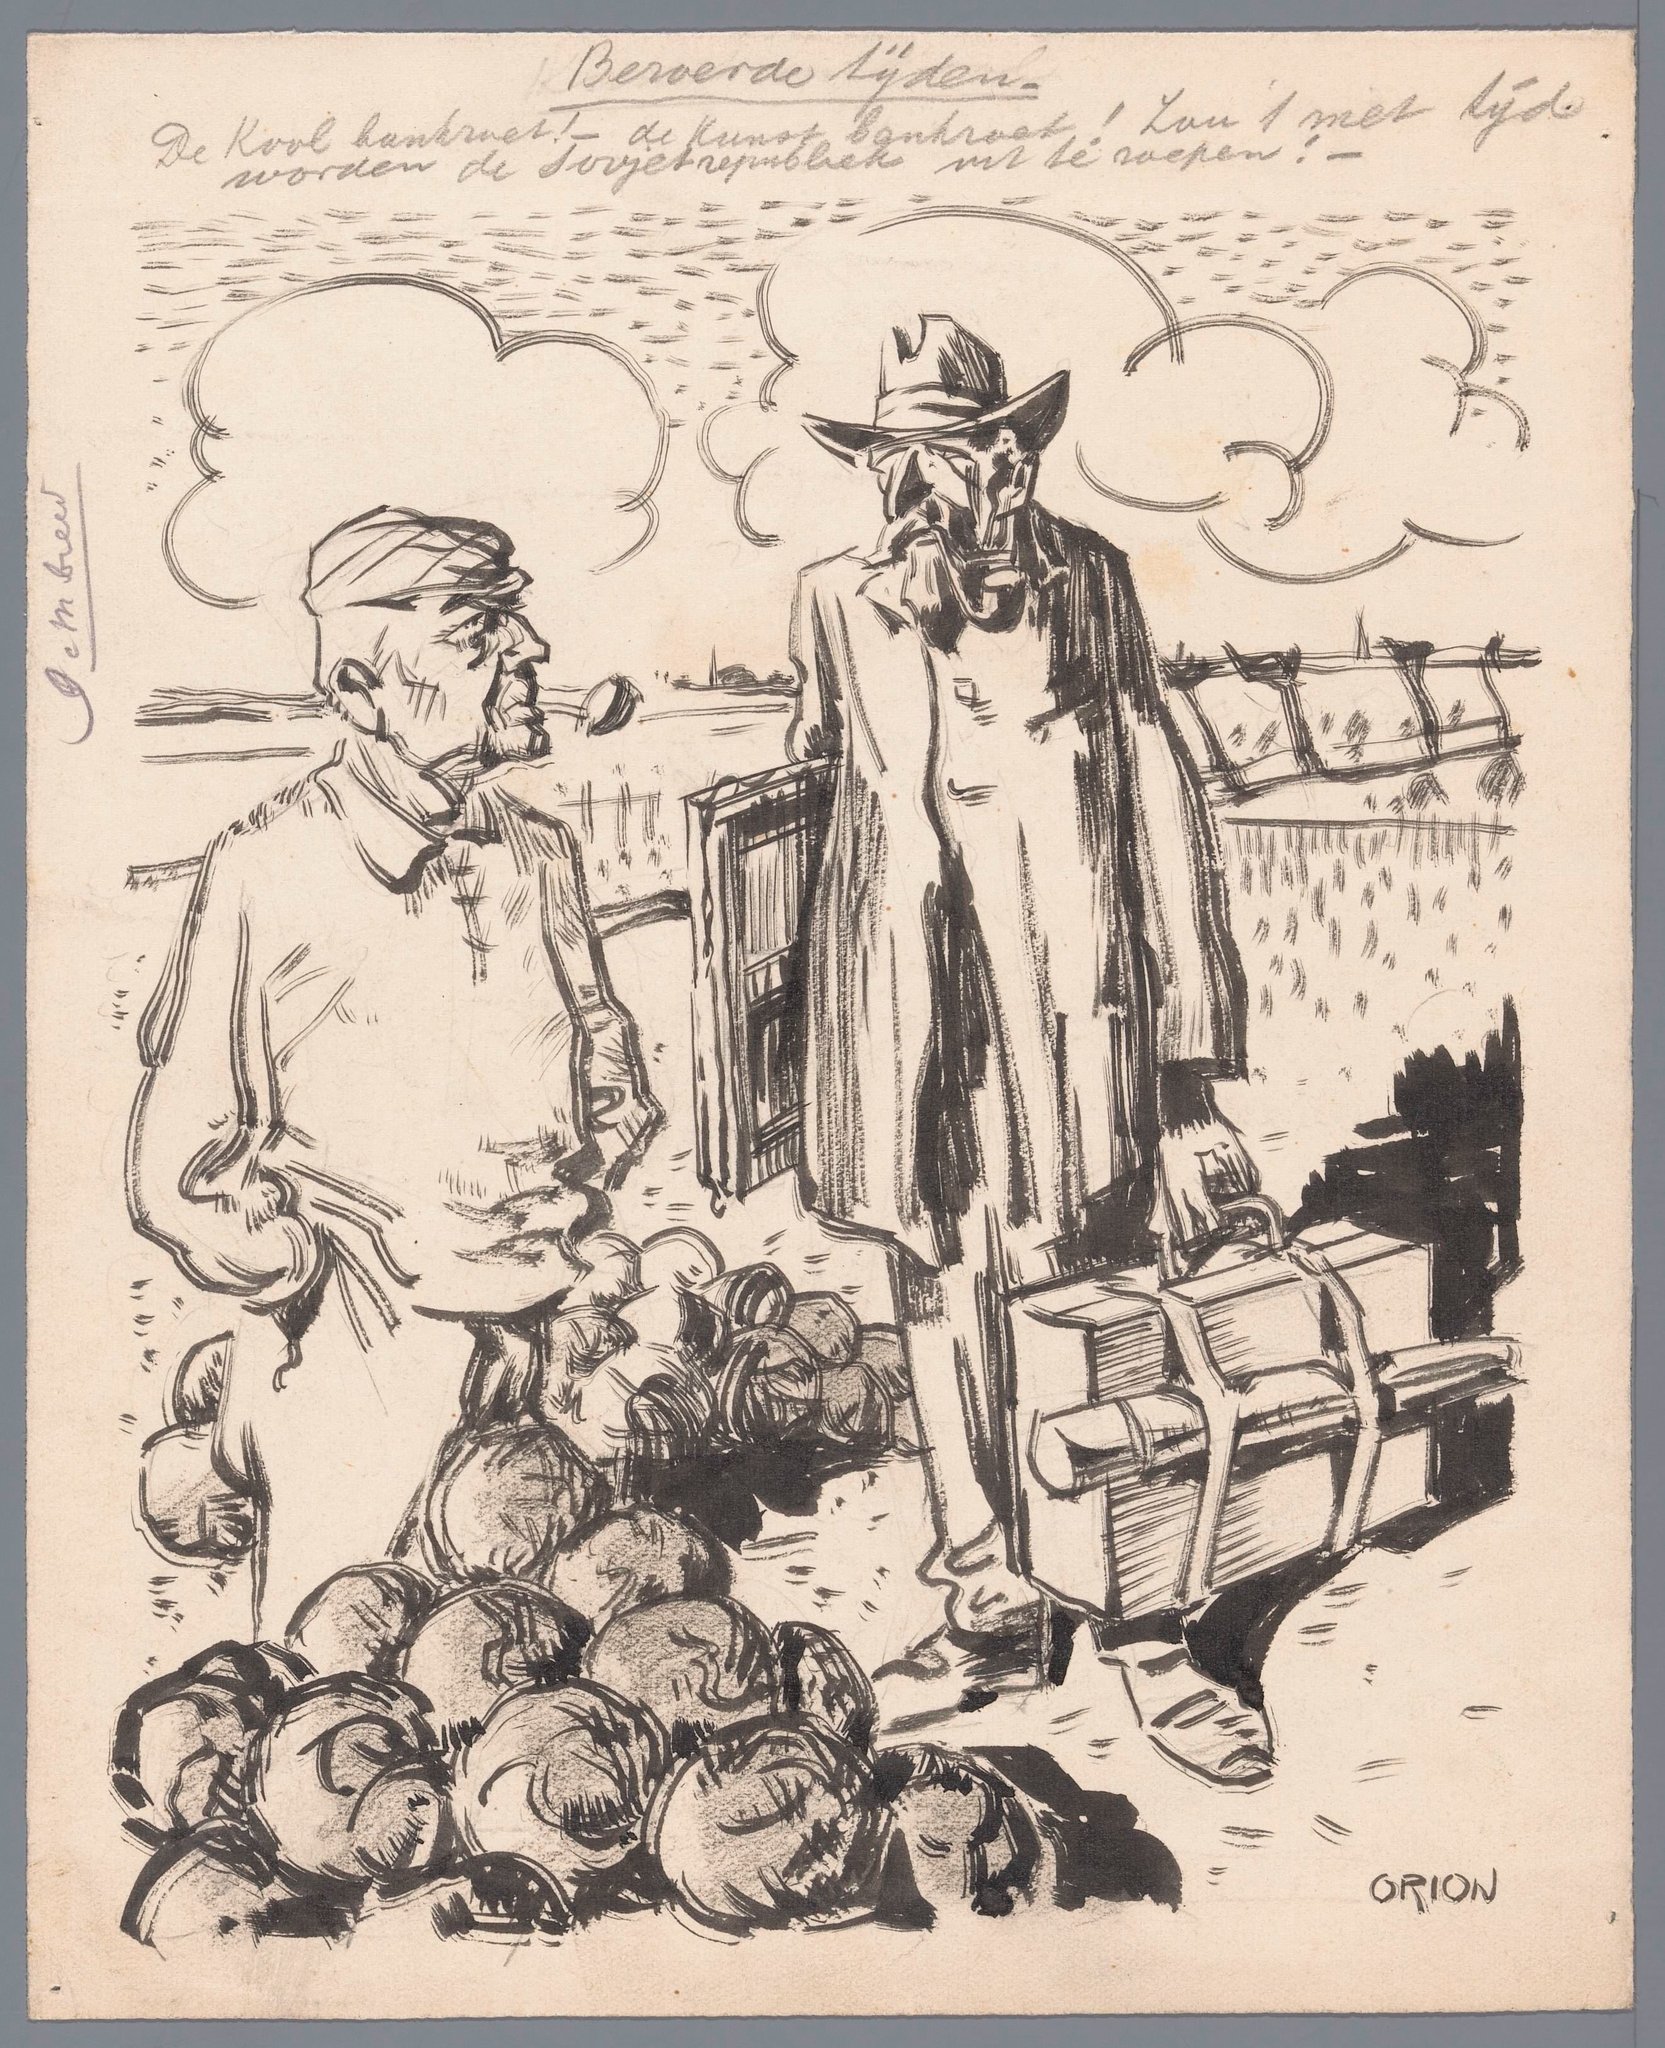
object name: cartoon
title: Boer en kunstenaar bankroet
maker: patricq kroon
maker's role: draughtsman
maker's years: 1862-1941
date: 1920-1935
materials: ink, paper, pencil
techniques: brush, pen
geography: netherlands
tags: unemployment, farmers, artist in non-work situation, political caricatures and satires, netherlands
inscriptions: inscription: ‘Beroerde tijden / De Kool bankroet! - de kunst bankroet! Zou 't niet tijd worden de Sovjet republiek uit te roepen!’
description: De boer en de kunstenaar kunnen hun producten niet verkopen. Ontwerp voor een politieke spotprent.